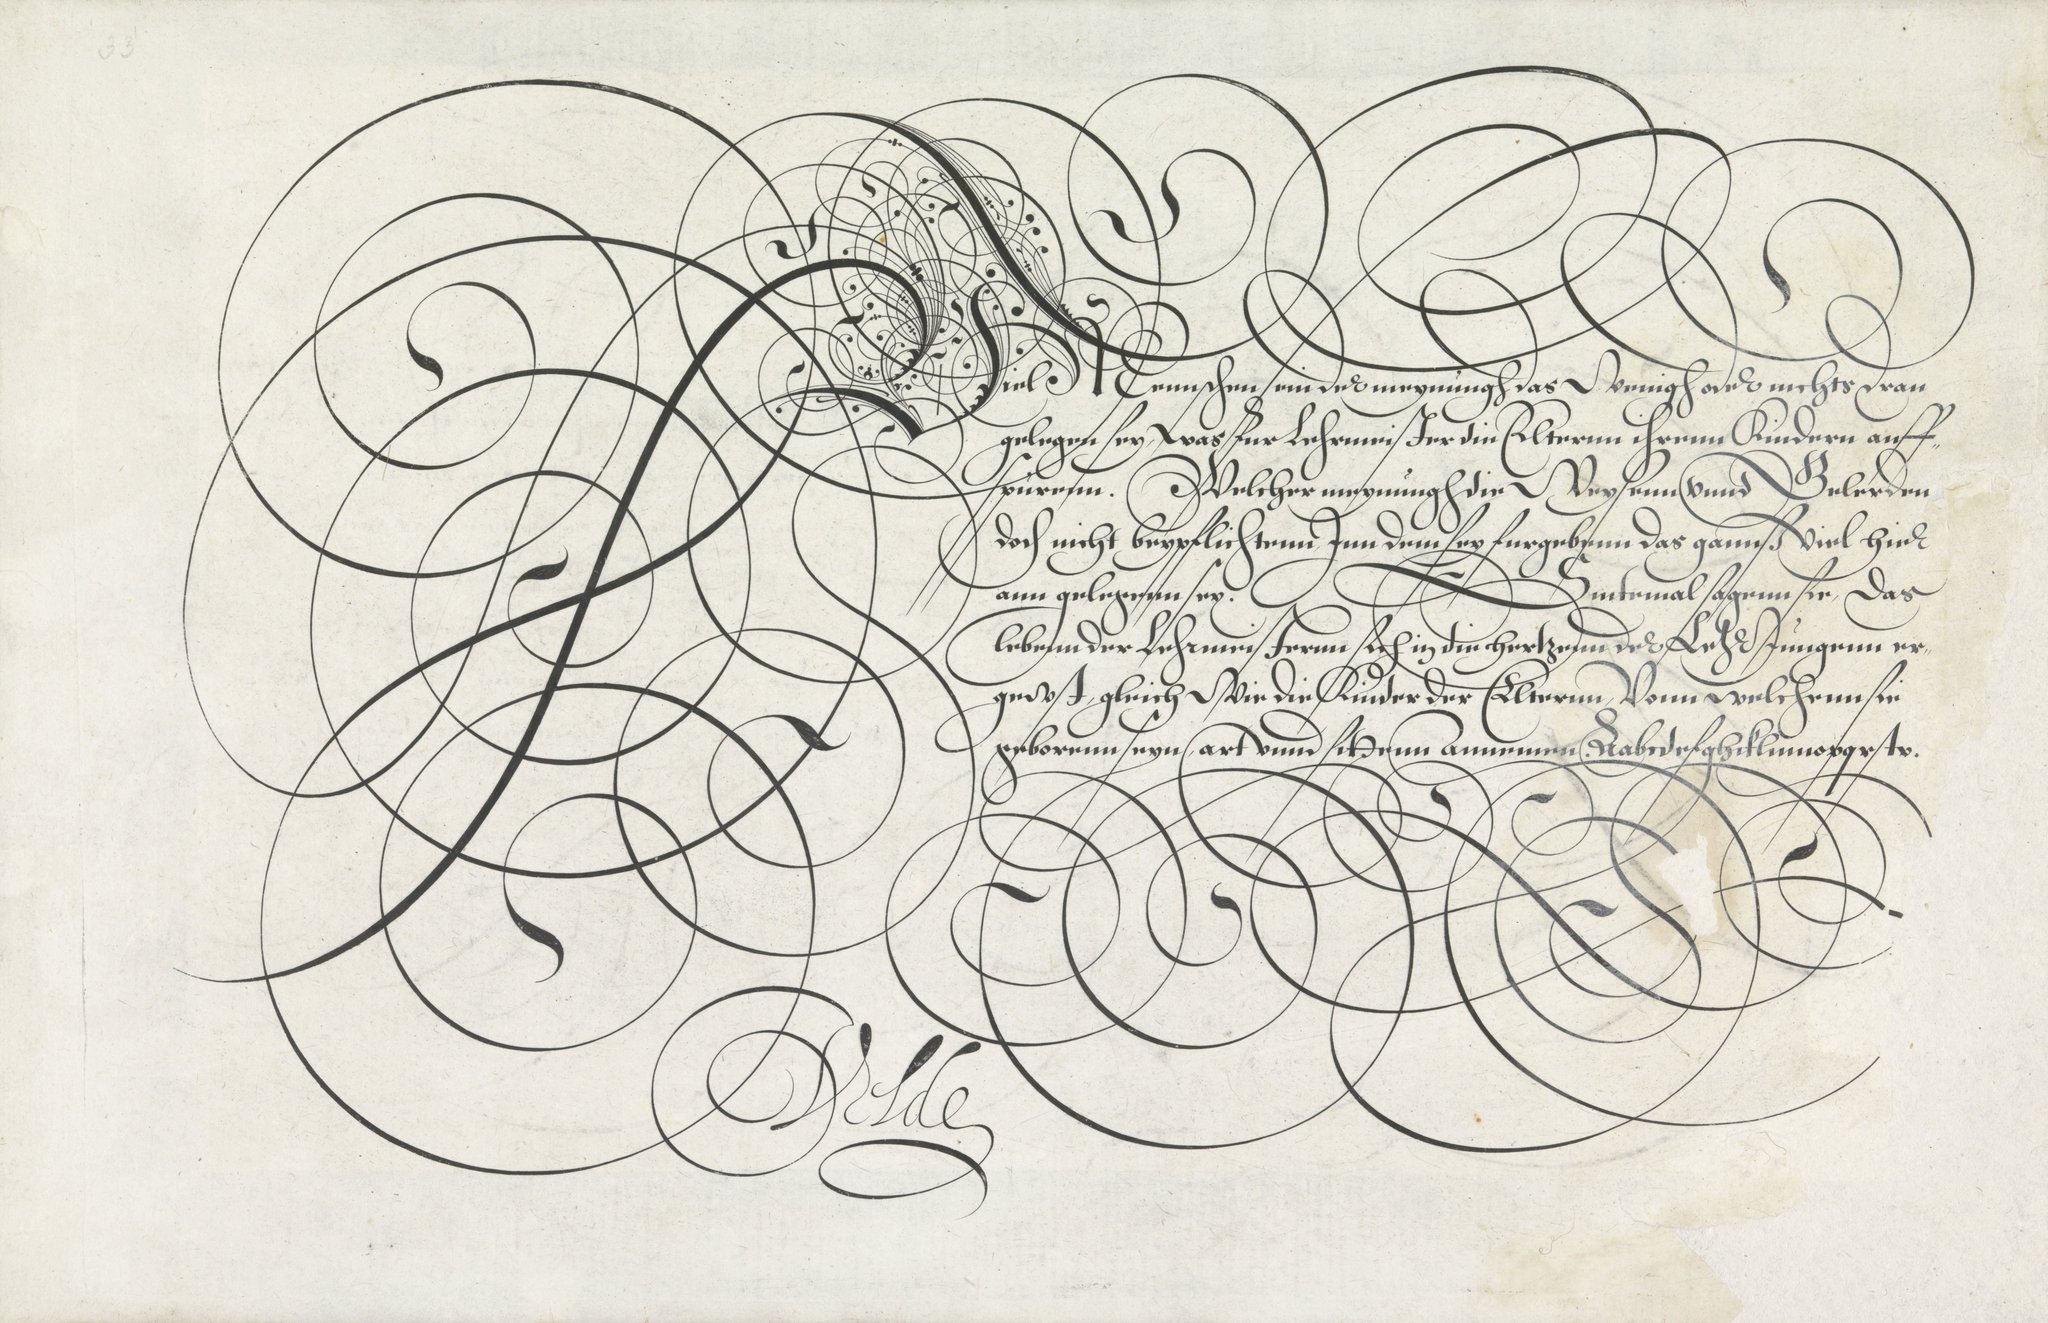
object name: album leaf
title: Spieghel der schrijfkonste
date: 1605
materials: paper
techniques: engraving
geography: haarlem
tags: calligraphy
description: Schrijfvoorbeeld met geornamenteerde initiaal V en acht regels tekst in het Duits: Viel menschen ... Onderaan een onderkastalfabet in de betreffende hand. De tekst is omlijst door krulwerk. De prent maakt deel uit van een album.